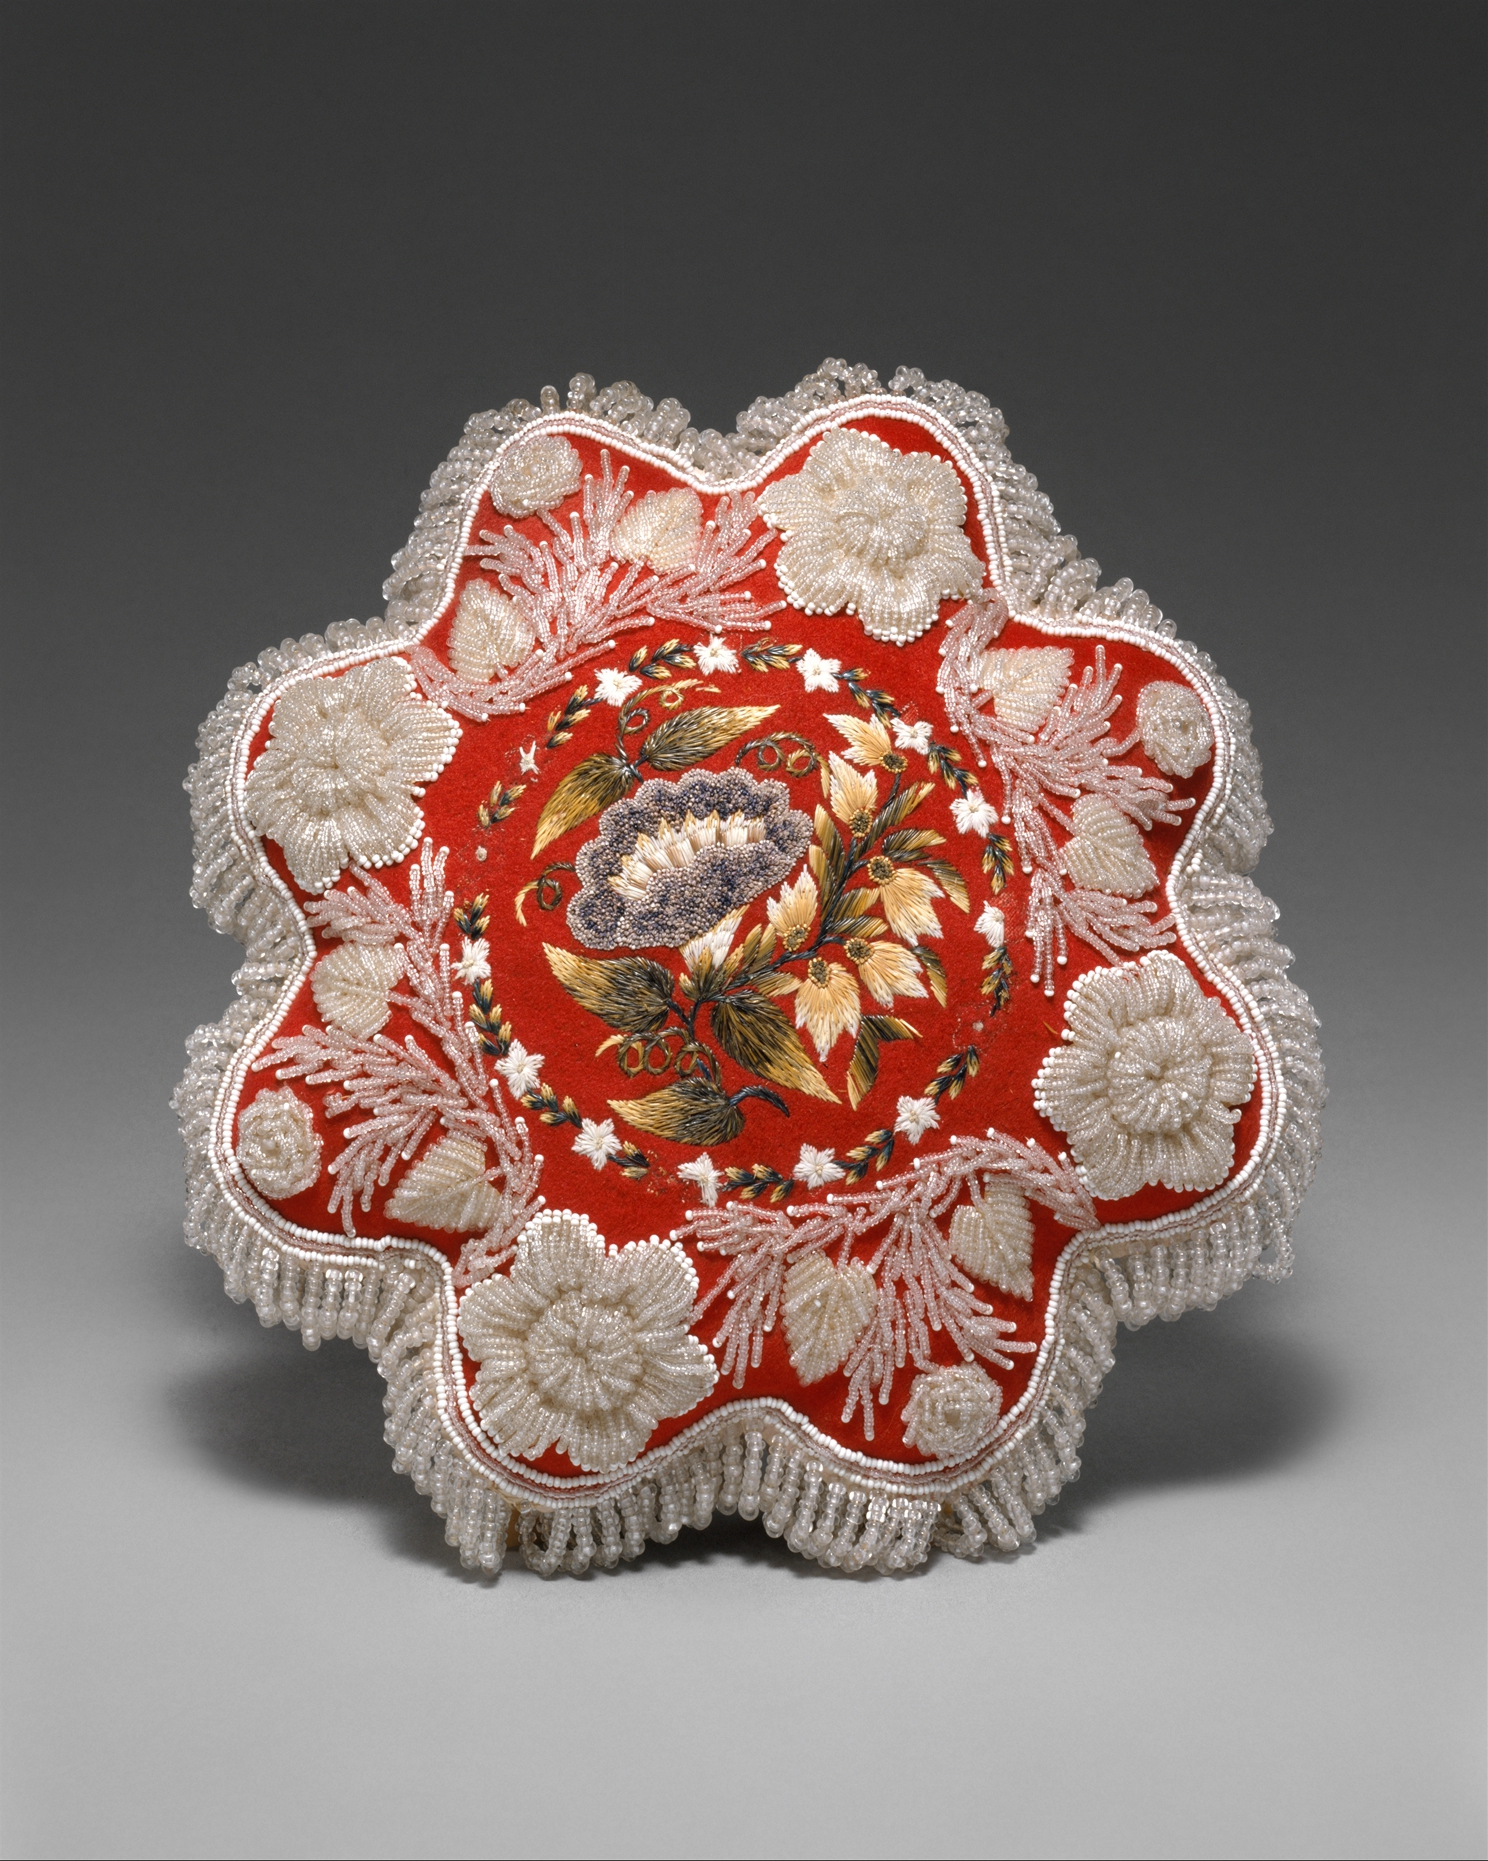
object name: pincushion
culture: huron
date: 1834-1866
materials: glass, silk, wool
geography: canada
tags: flowers,leaves